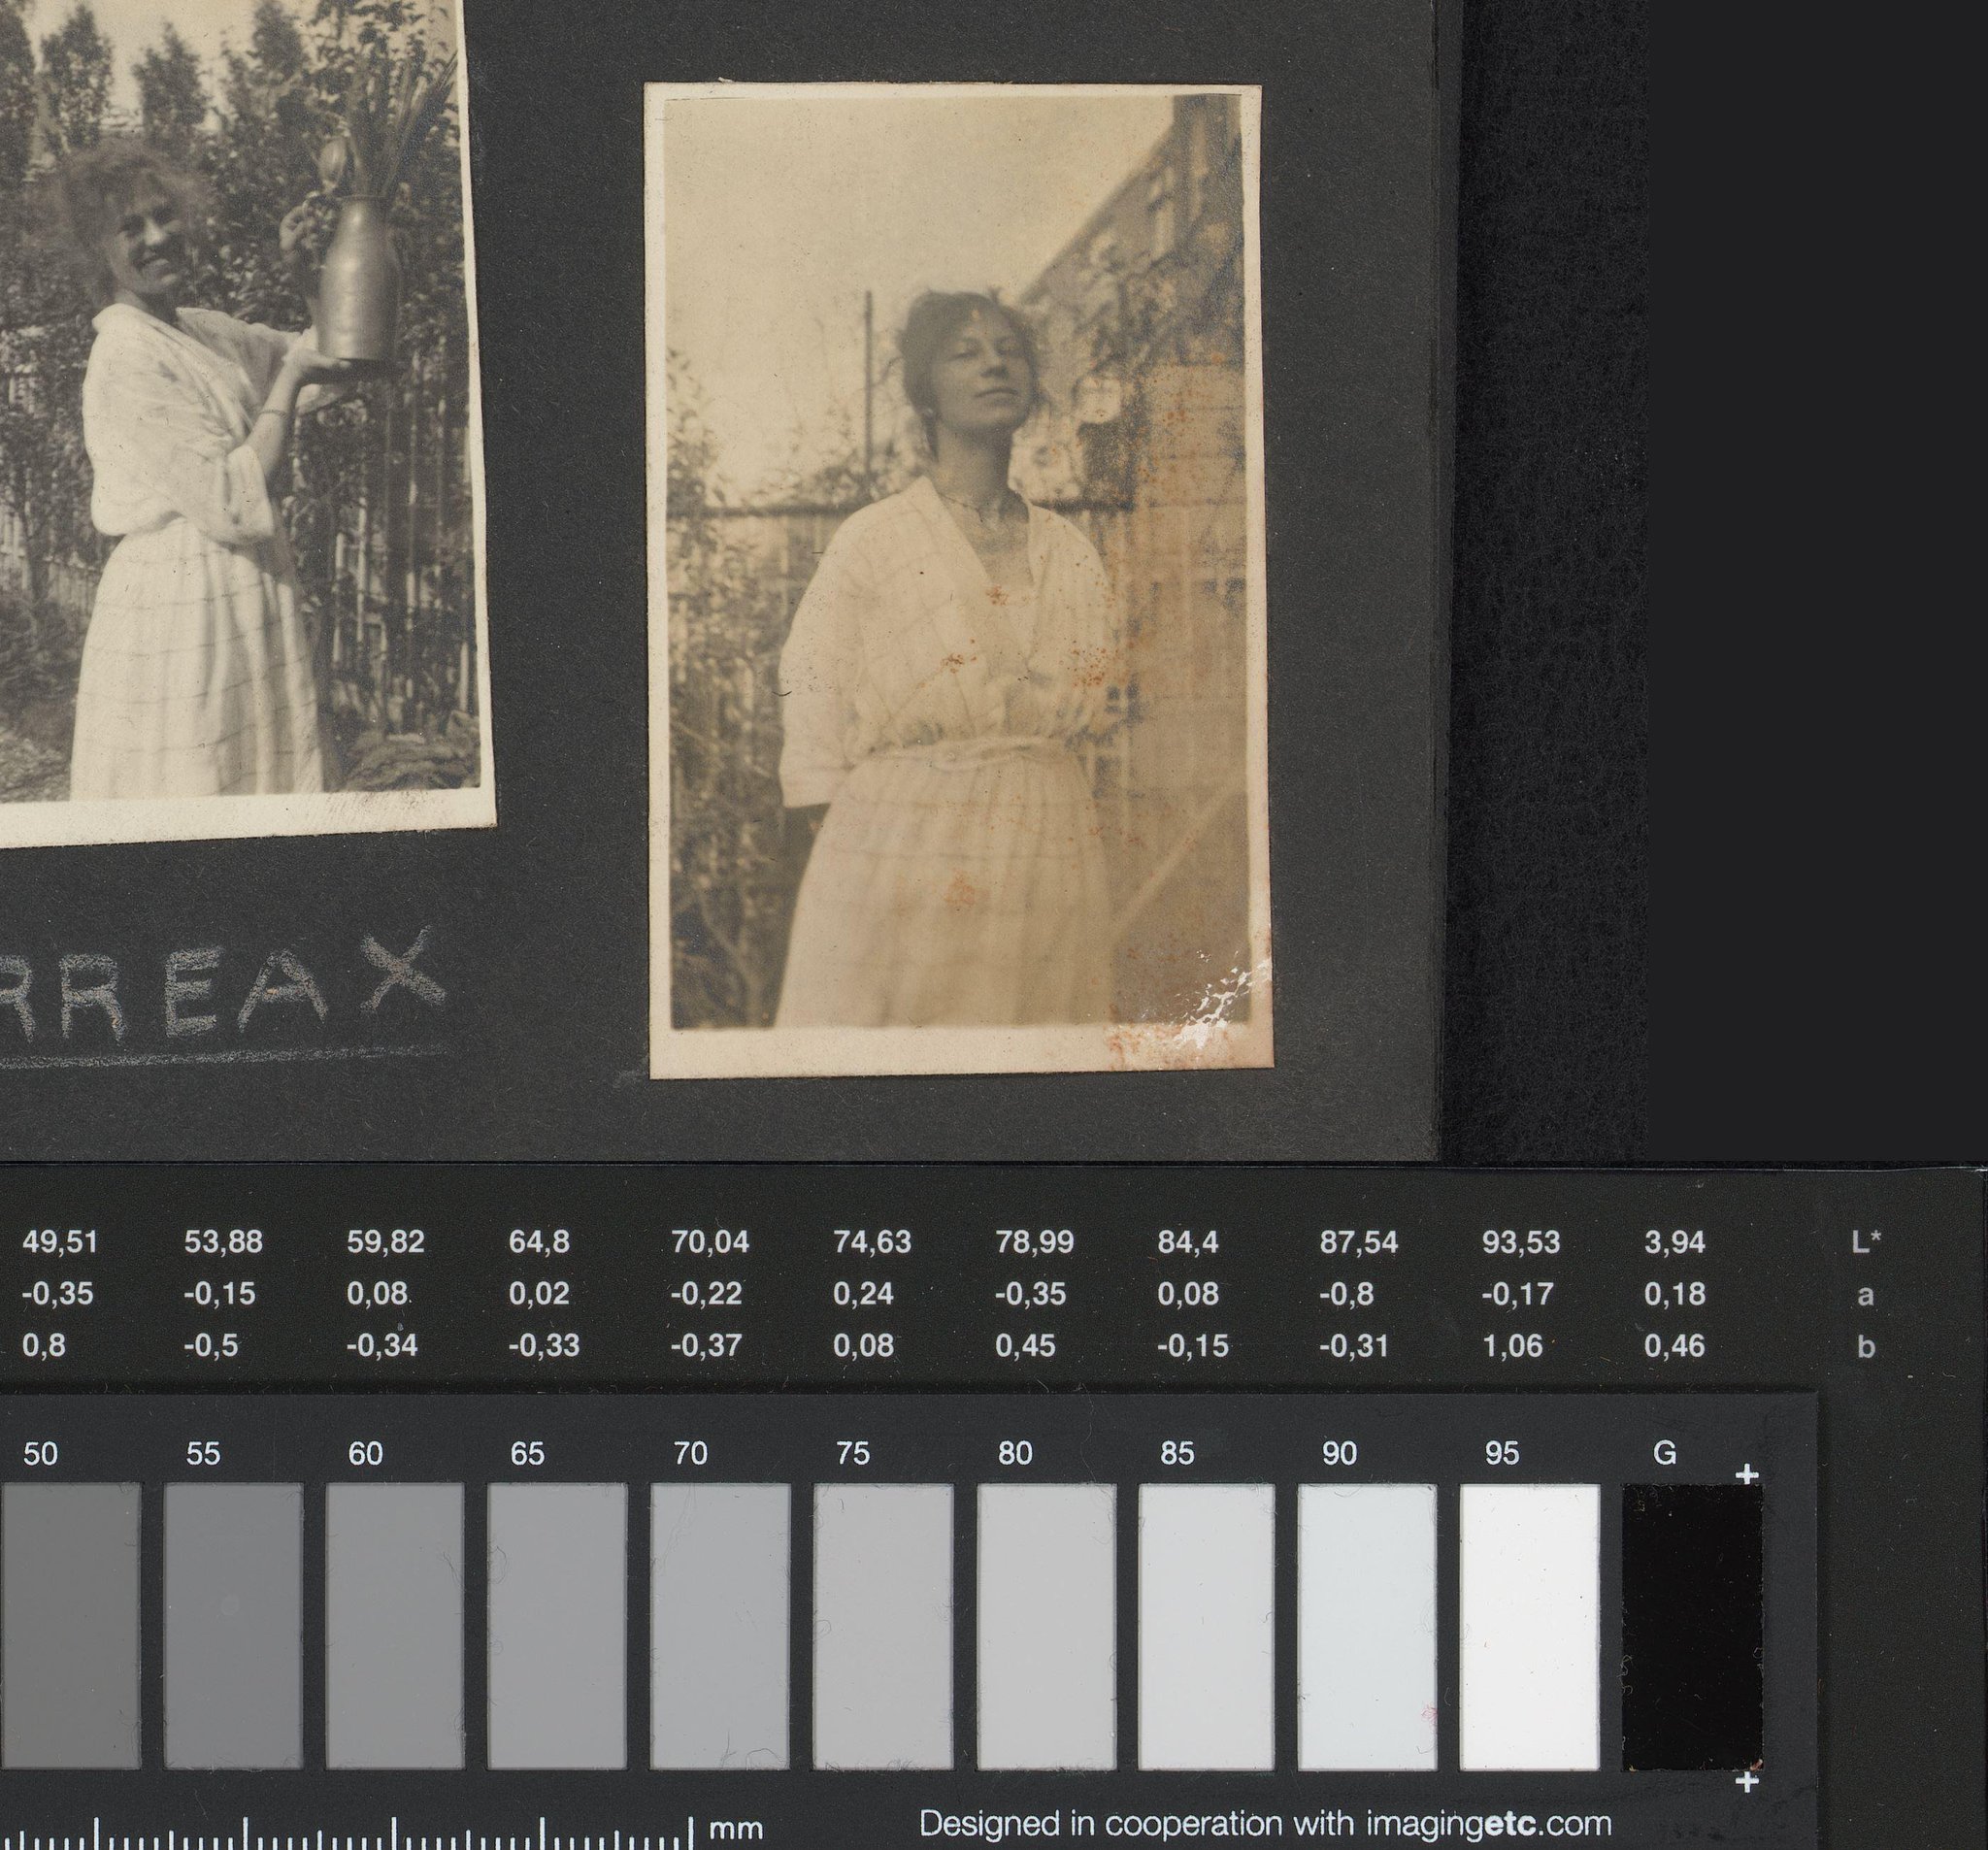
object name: album leaf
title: Carreax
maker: Anonymous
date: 1920-1925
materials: paper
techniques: gelatin silver print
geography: south holland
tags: adult woman